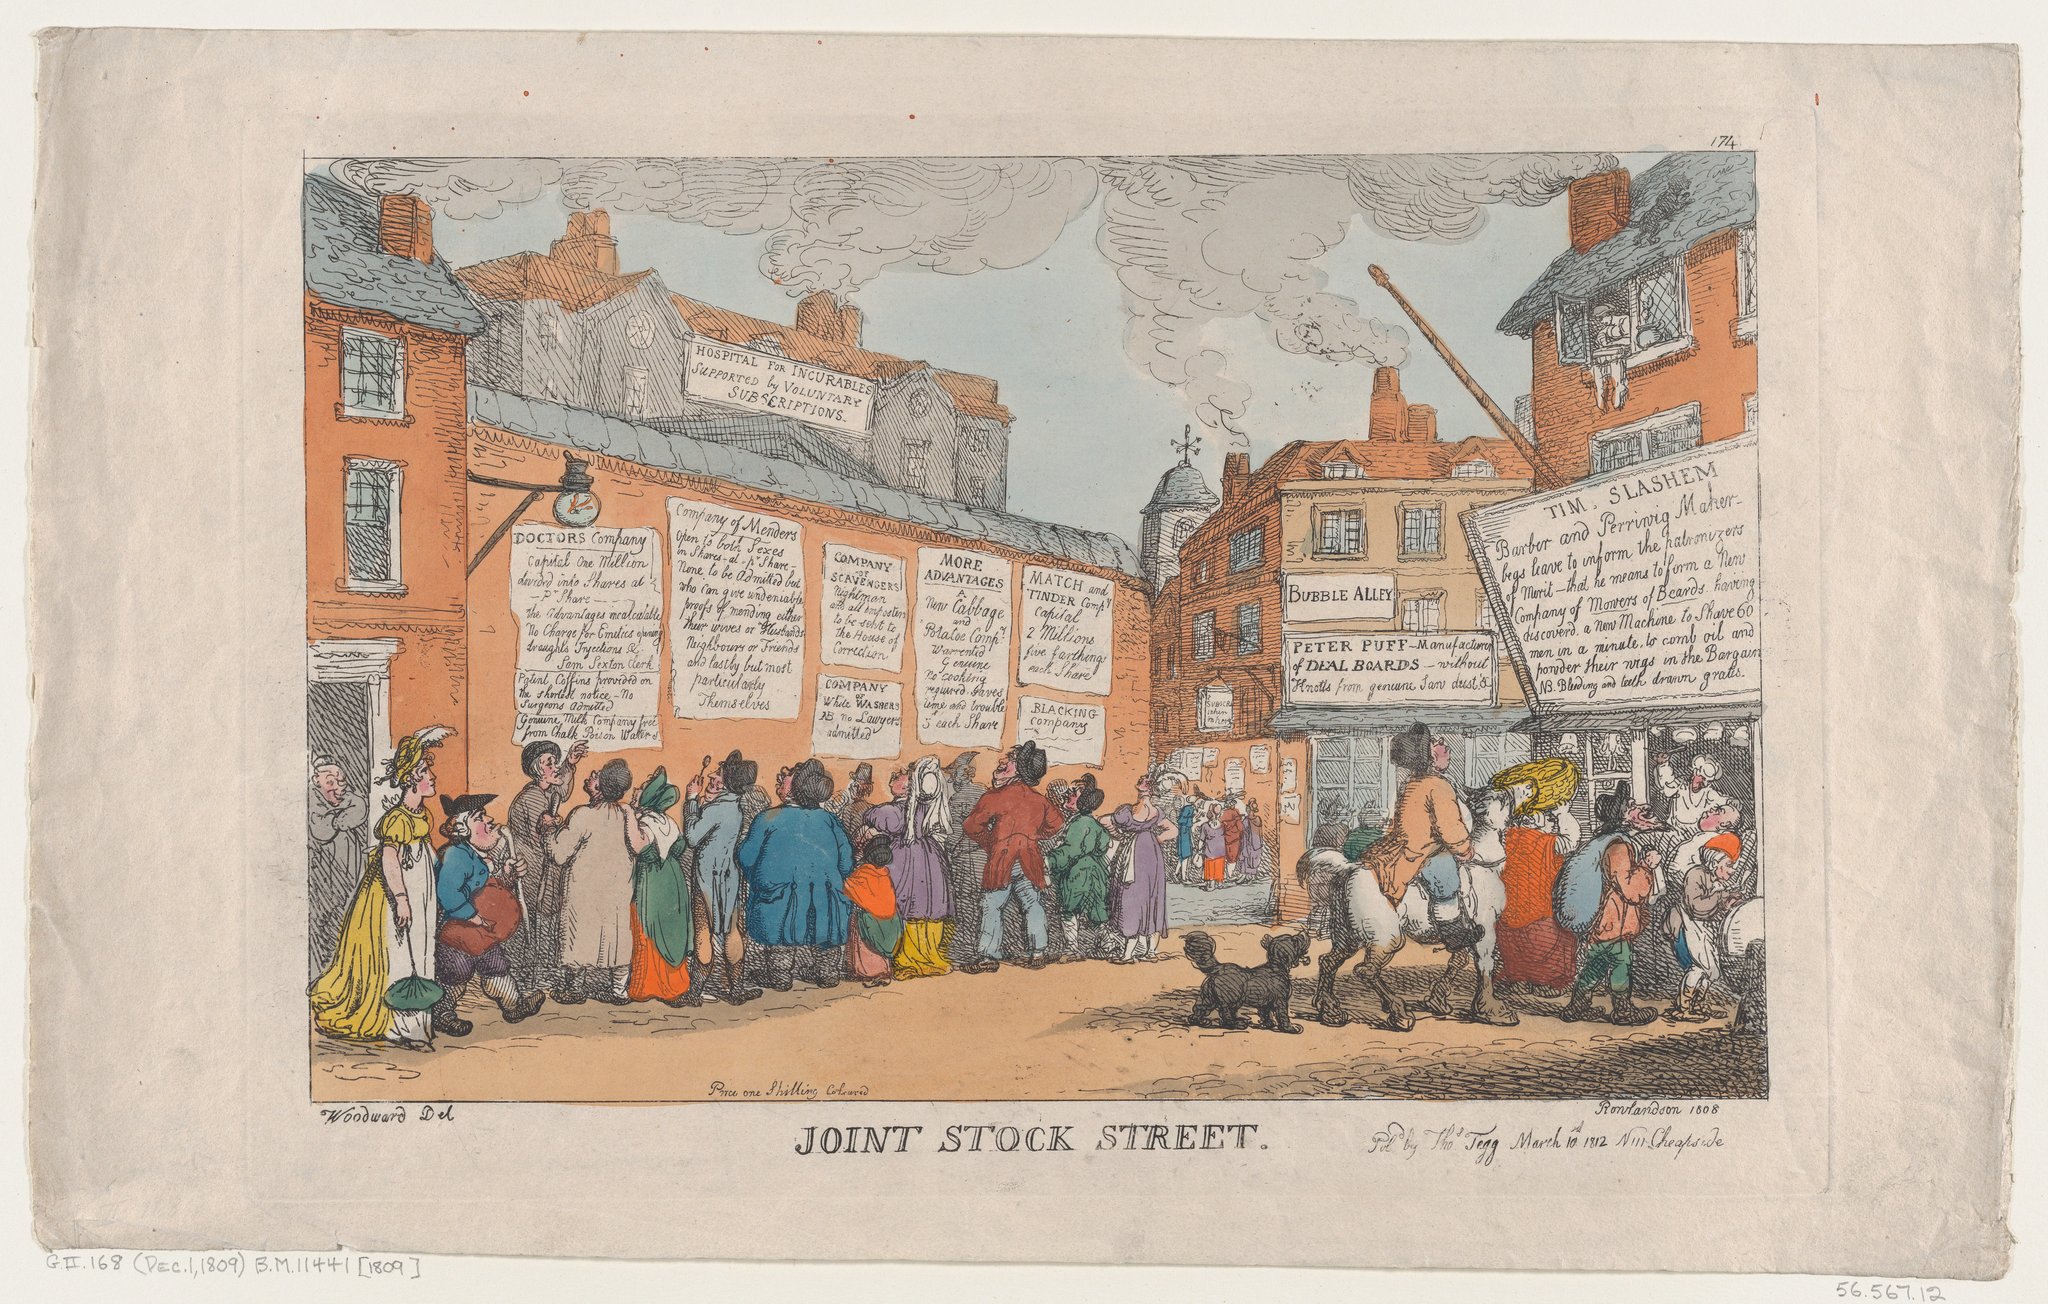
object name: print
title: Joint Stock Street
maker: thomas rowlandson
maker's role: artist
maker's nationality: british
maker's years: 1757-1827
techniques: etching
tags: streets,men,women,horses,crowd